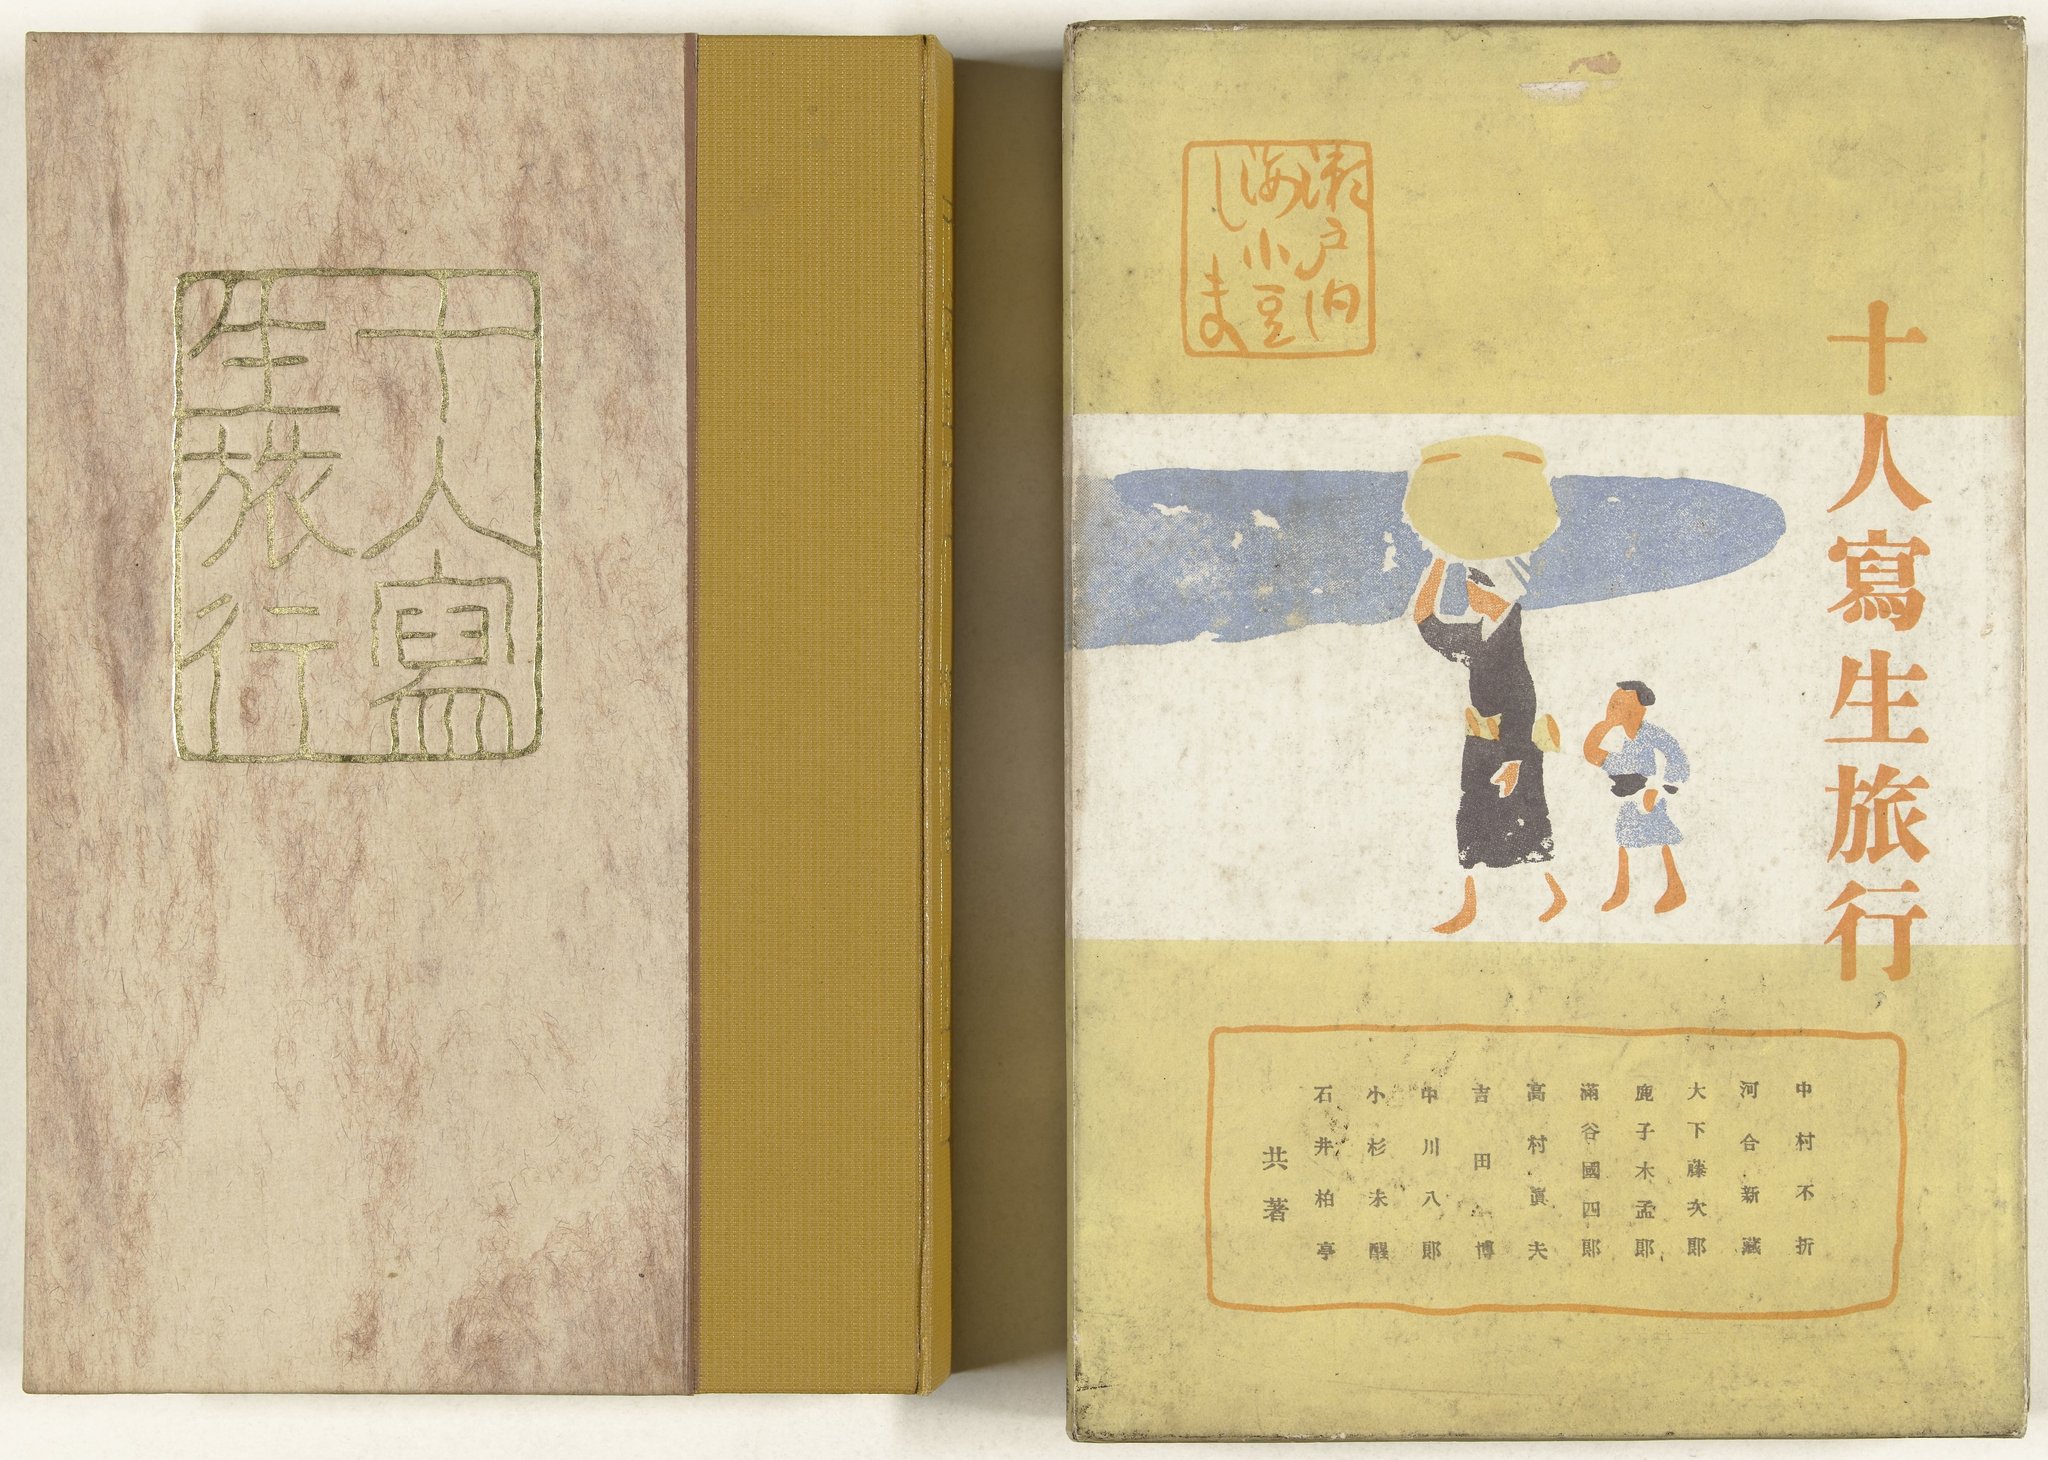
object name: book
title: Schetstocht van tien kunstenaars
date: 1902-1911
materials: paper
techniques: woodcut, letterpress printing, lithograph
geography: japan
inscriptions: date